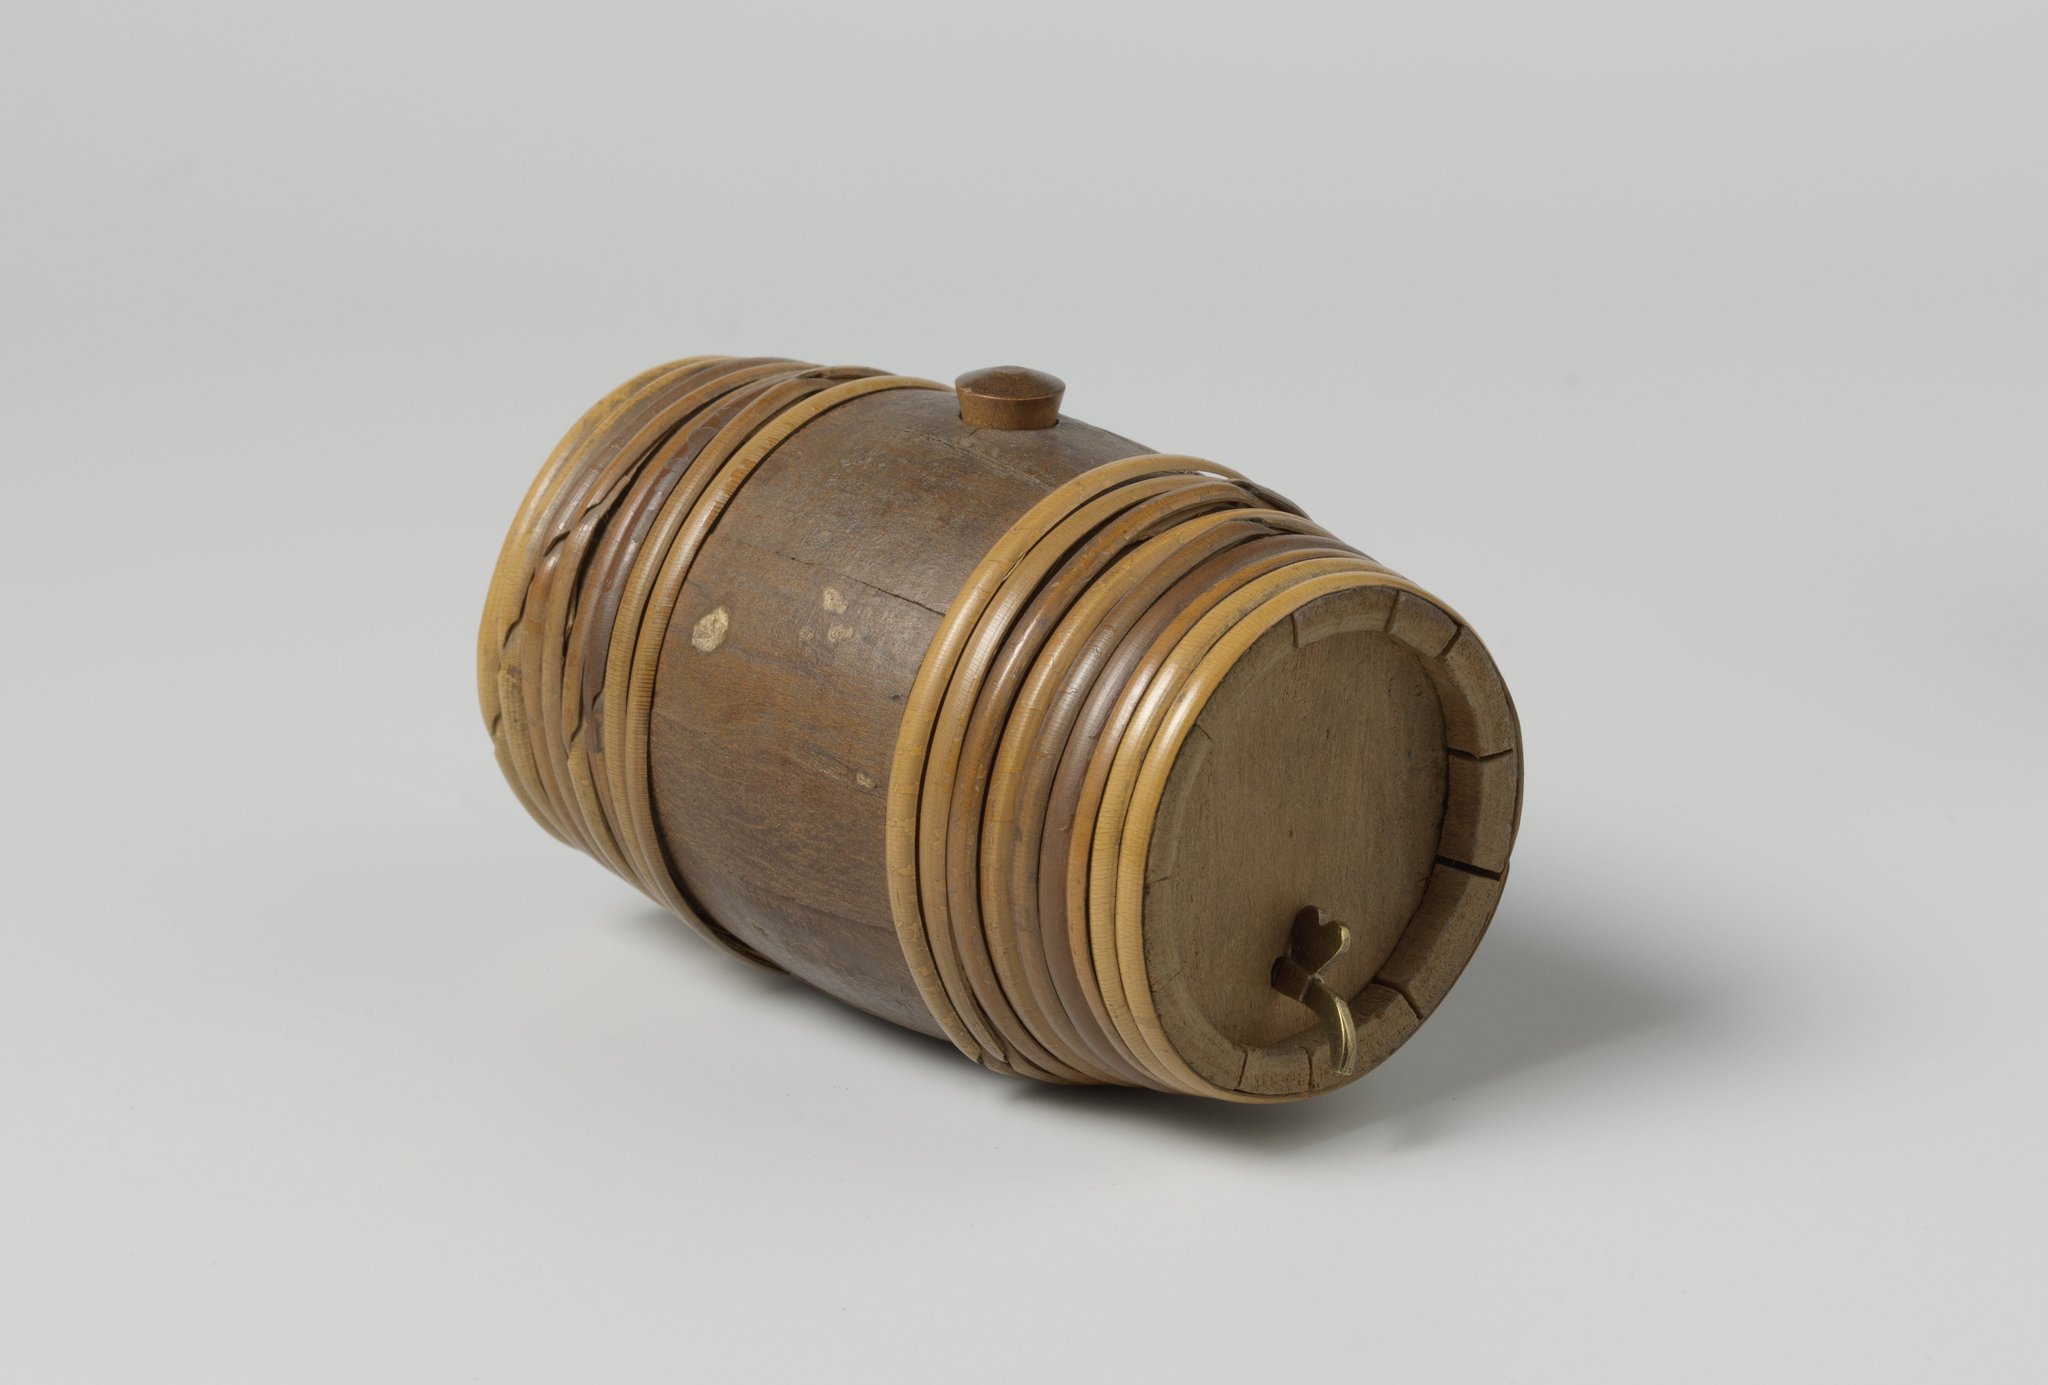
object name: biervat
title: Biervat, vervaardigd uit duigen en hoepels, met tapkraan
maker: Anonymous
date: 1700-1799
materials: bark, brass, rattan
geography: amsterdam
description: Biervat, gemaakt van losse duigen van de schors of het spinthout van een onbekende houtsoort, omworden door negen en acht hoepels van rotan. Bovenin een gat met een stop, voorin de ton een tapgat, waarin een losse tapkraan.